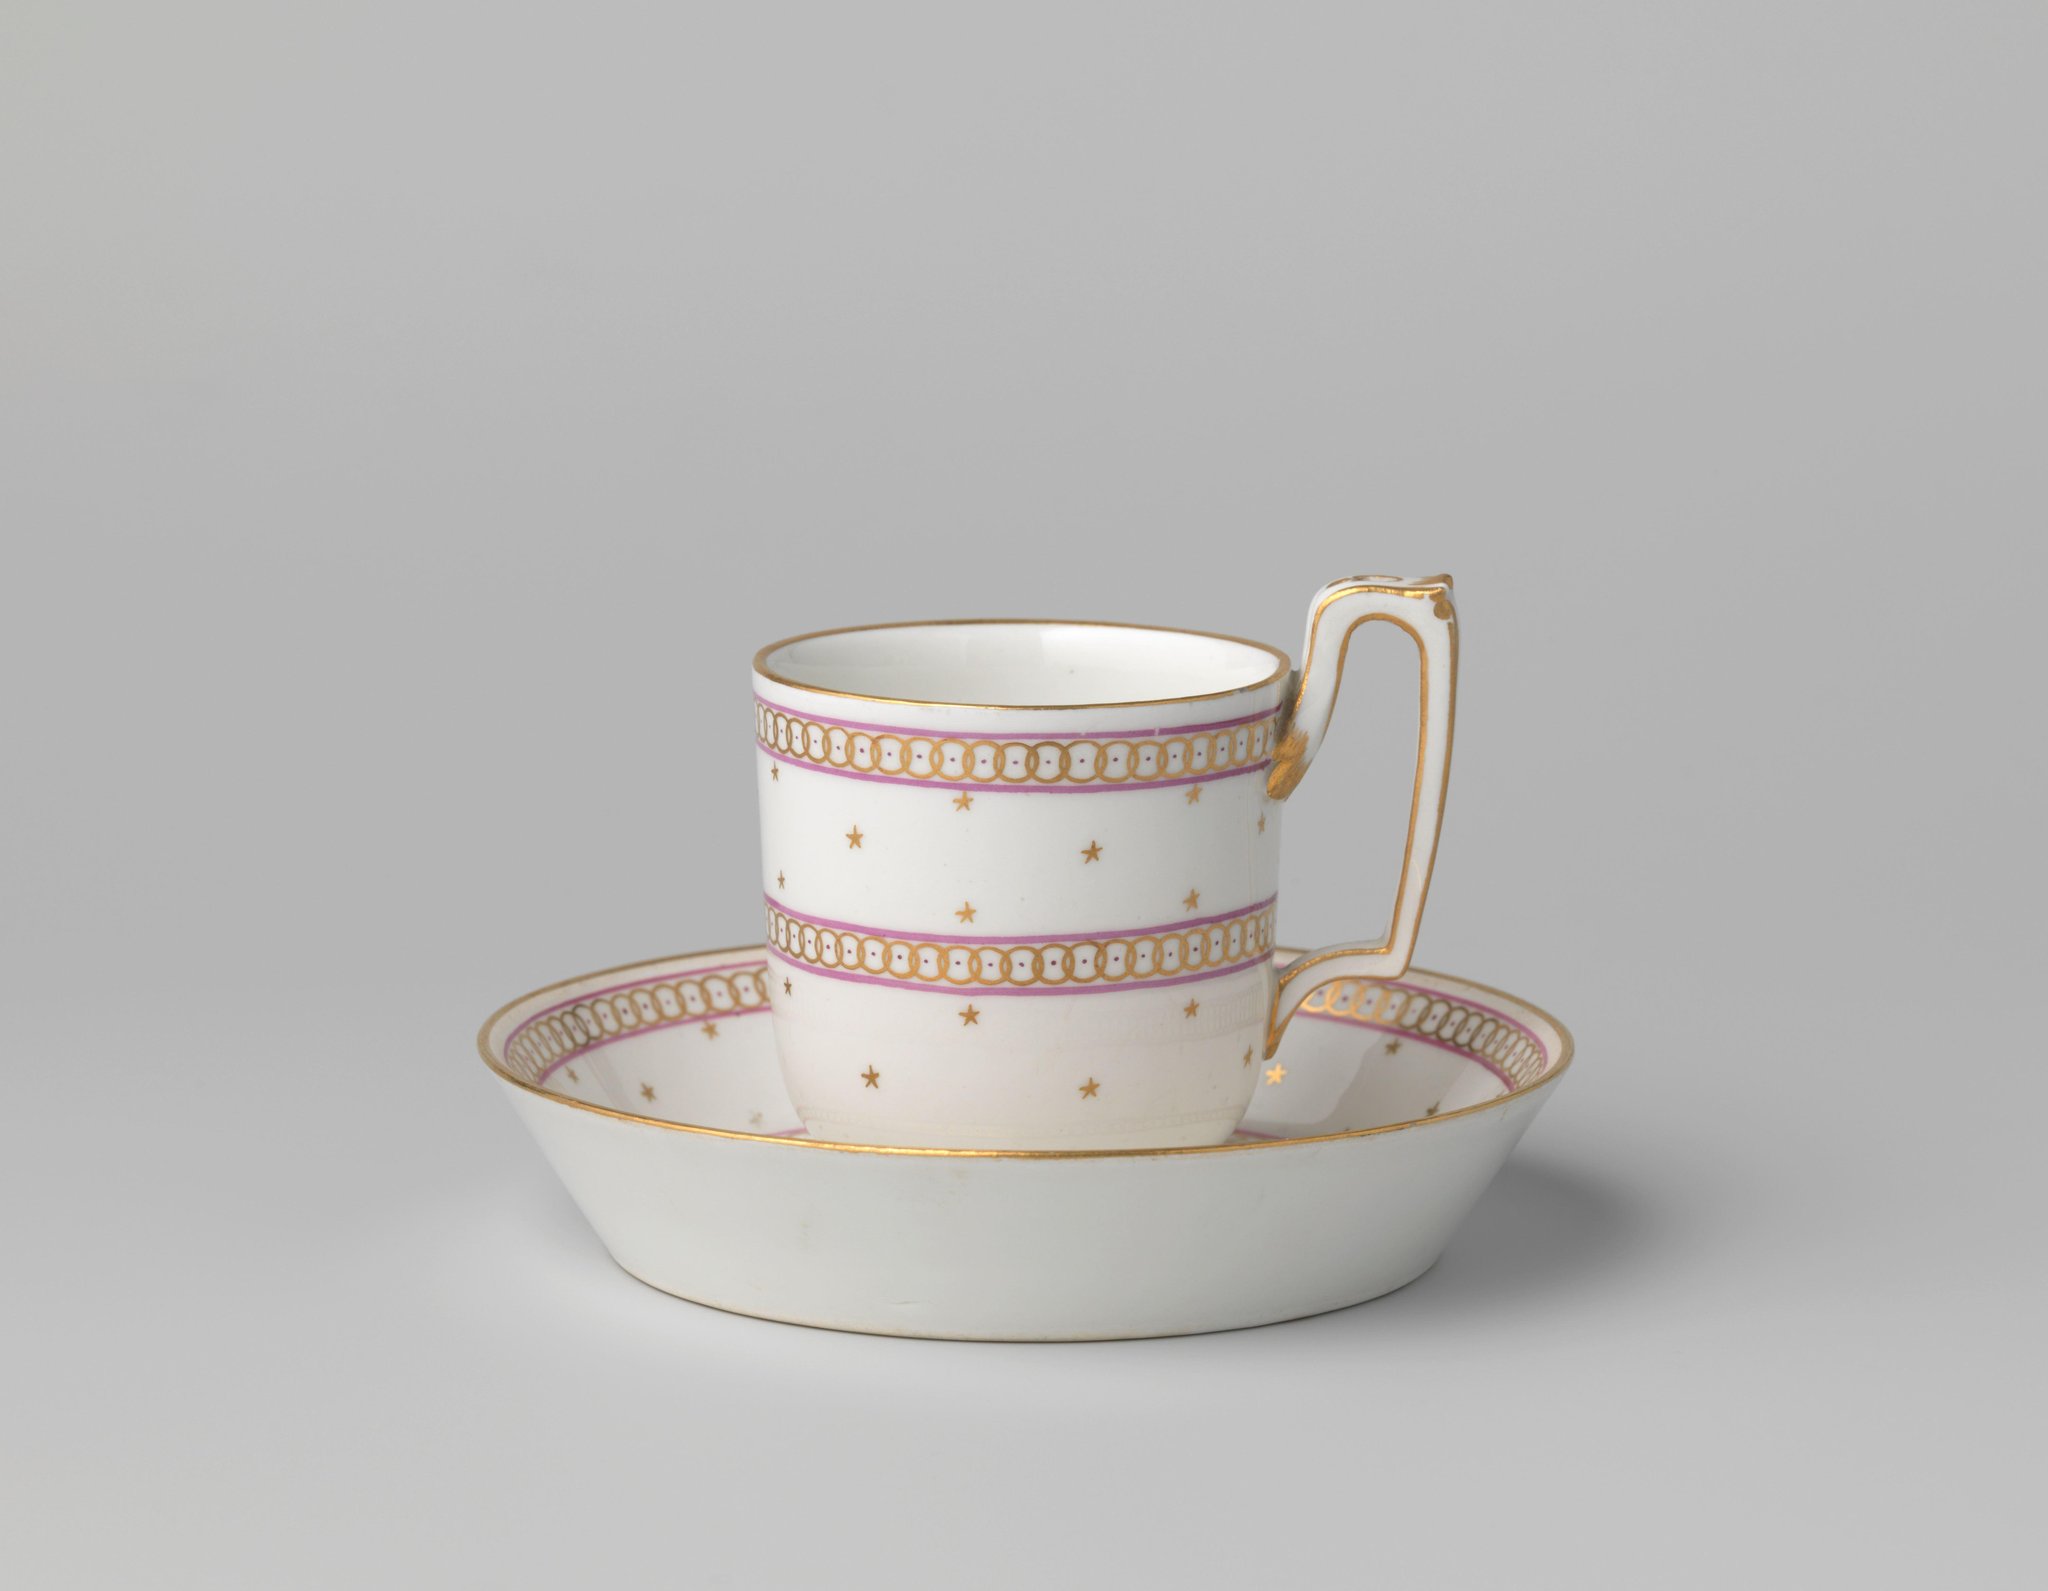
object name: kop en schotel, kop en schotel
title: Cup and saucer with stars and ornamental borders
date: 1791-1801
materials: glaze, gold, paint, porcelain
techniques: firing, forming, gilding, turning, vitrification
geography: vienna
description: Cup and saucer. Porcelain. Vienna, 1791. Given by Mrs J.E.F.E. de Kleyn-von Artner, 1956.